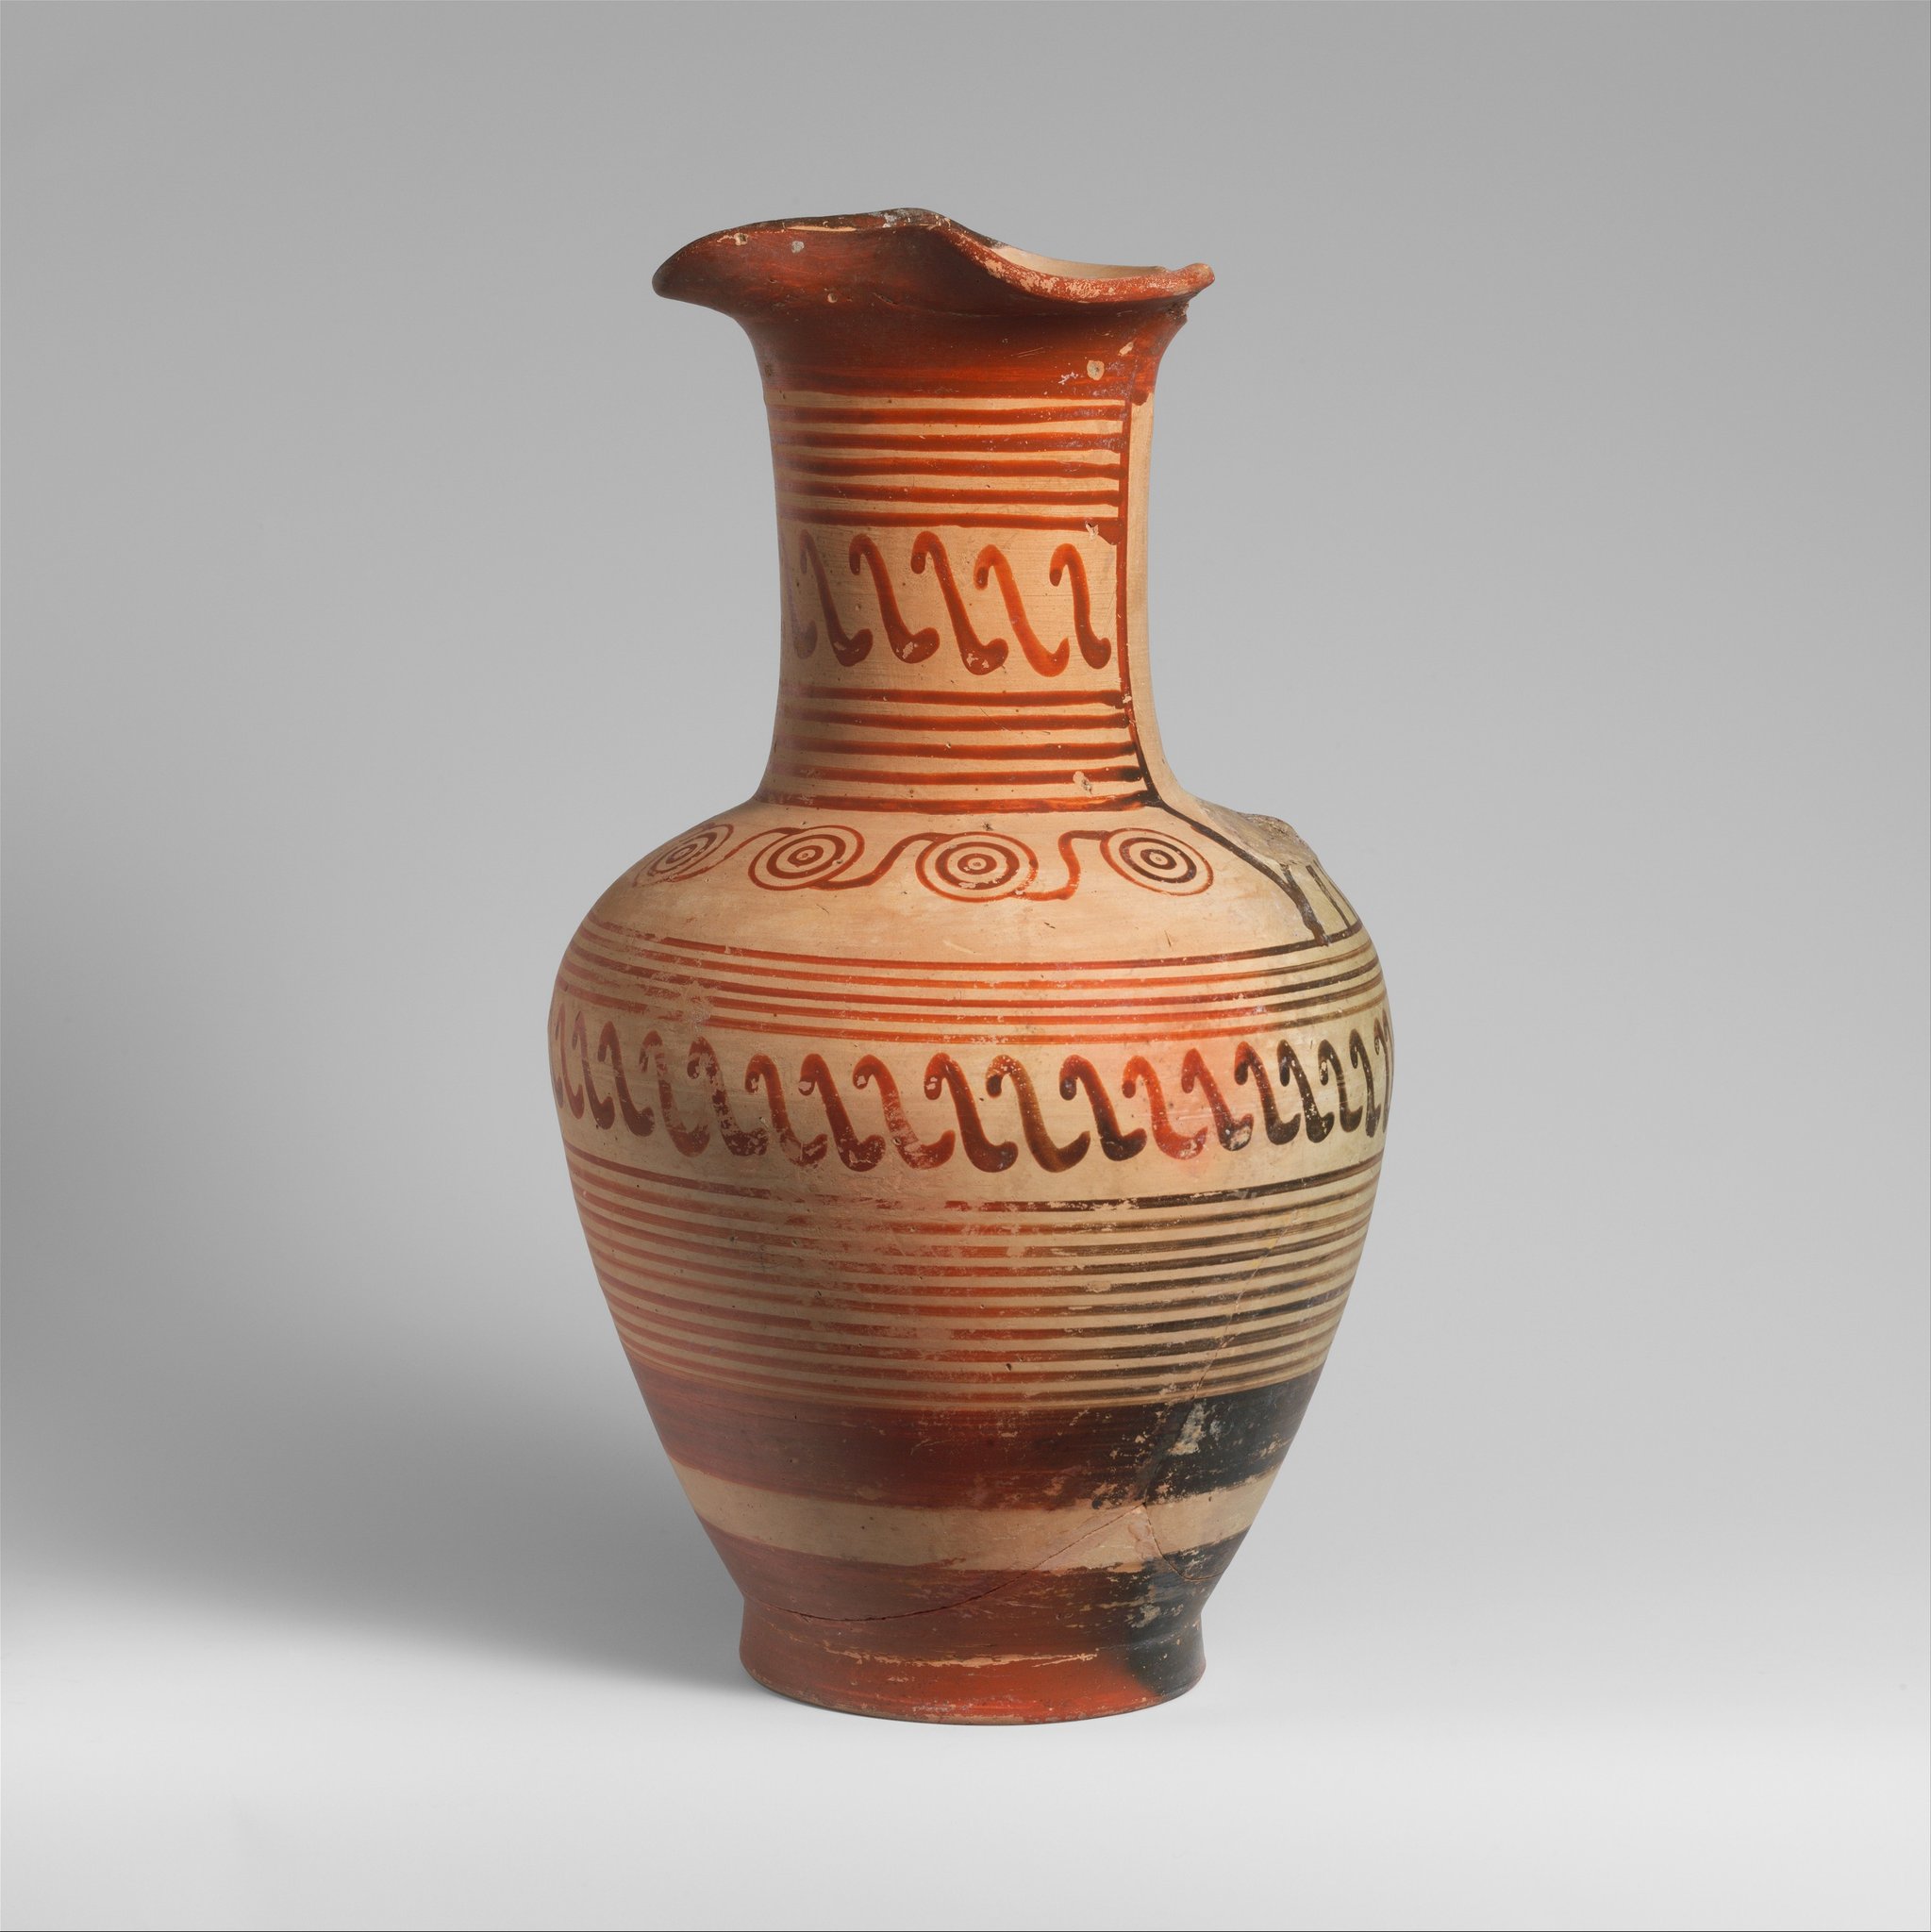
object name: oinochoe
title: Terracotta oinochoe (jug)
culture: greek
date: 734-668 BCE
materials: terracotta